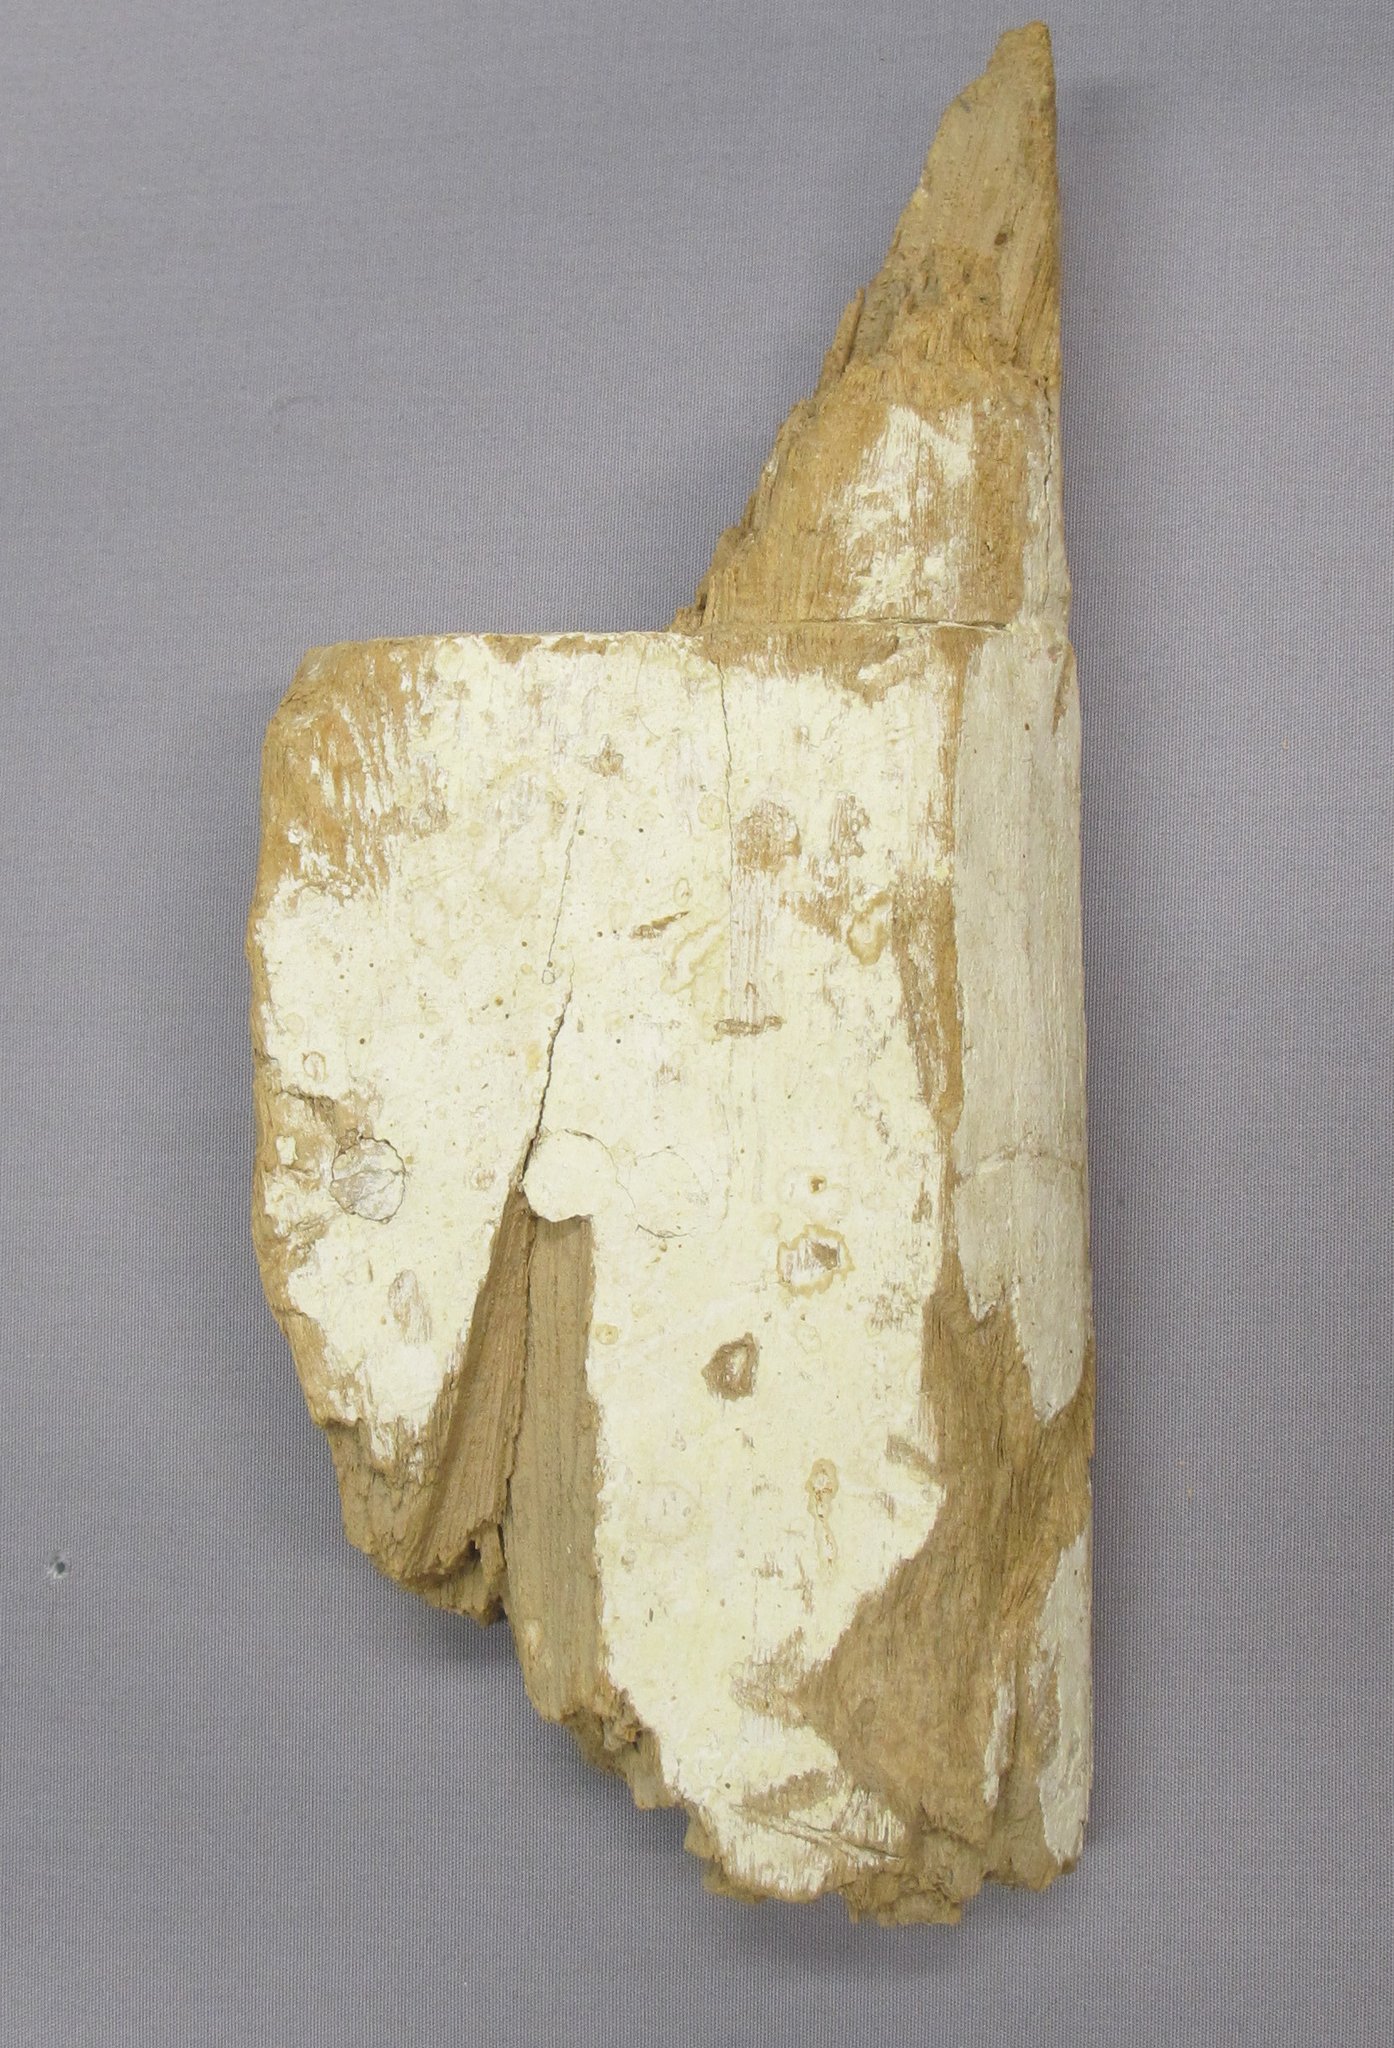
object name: door fragment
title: Fragment from a tomb door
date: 2150-1981 BCE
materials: paint, wood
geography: egypt